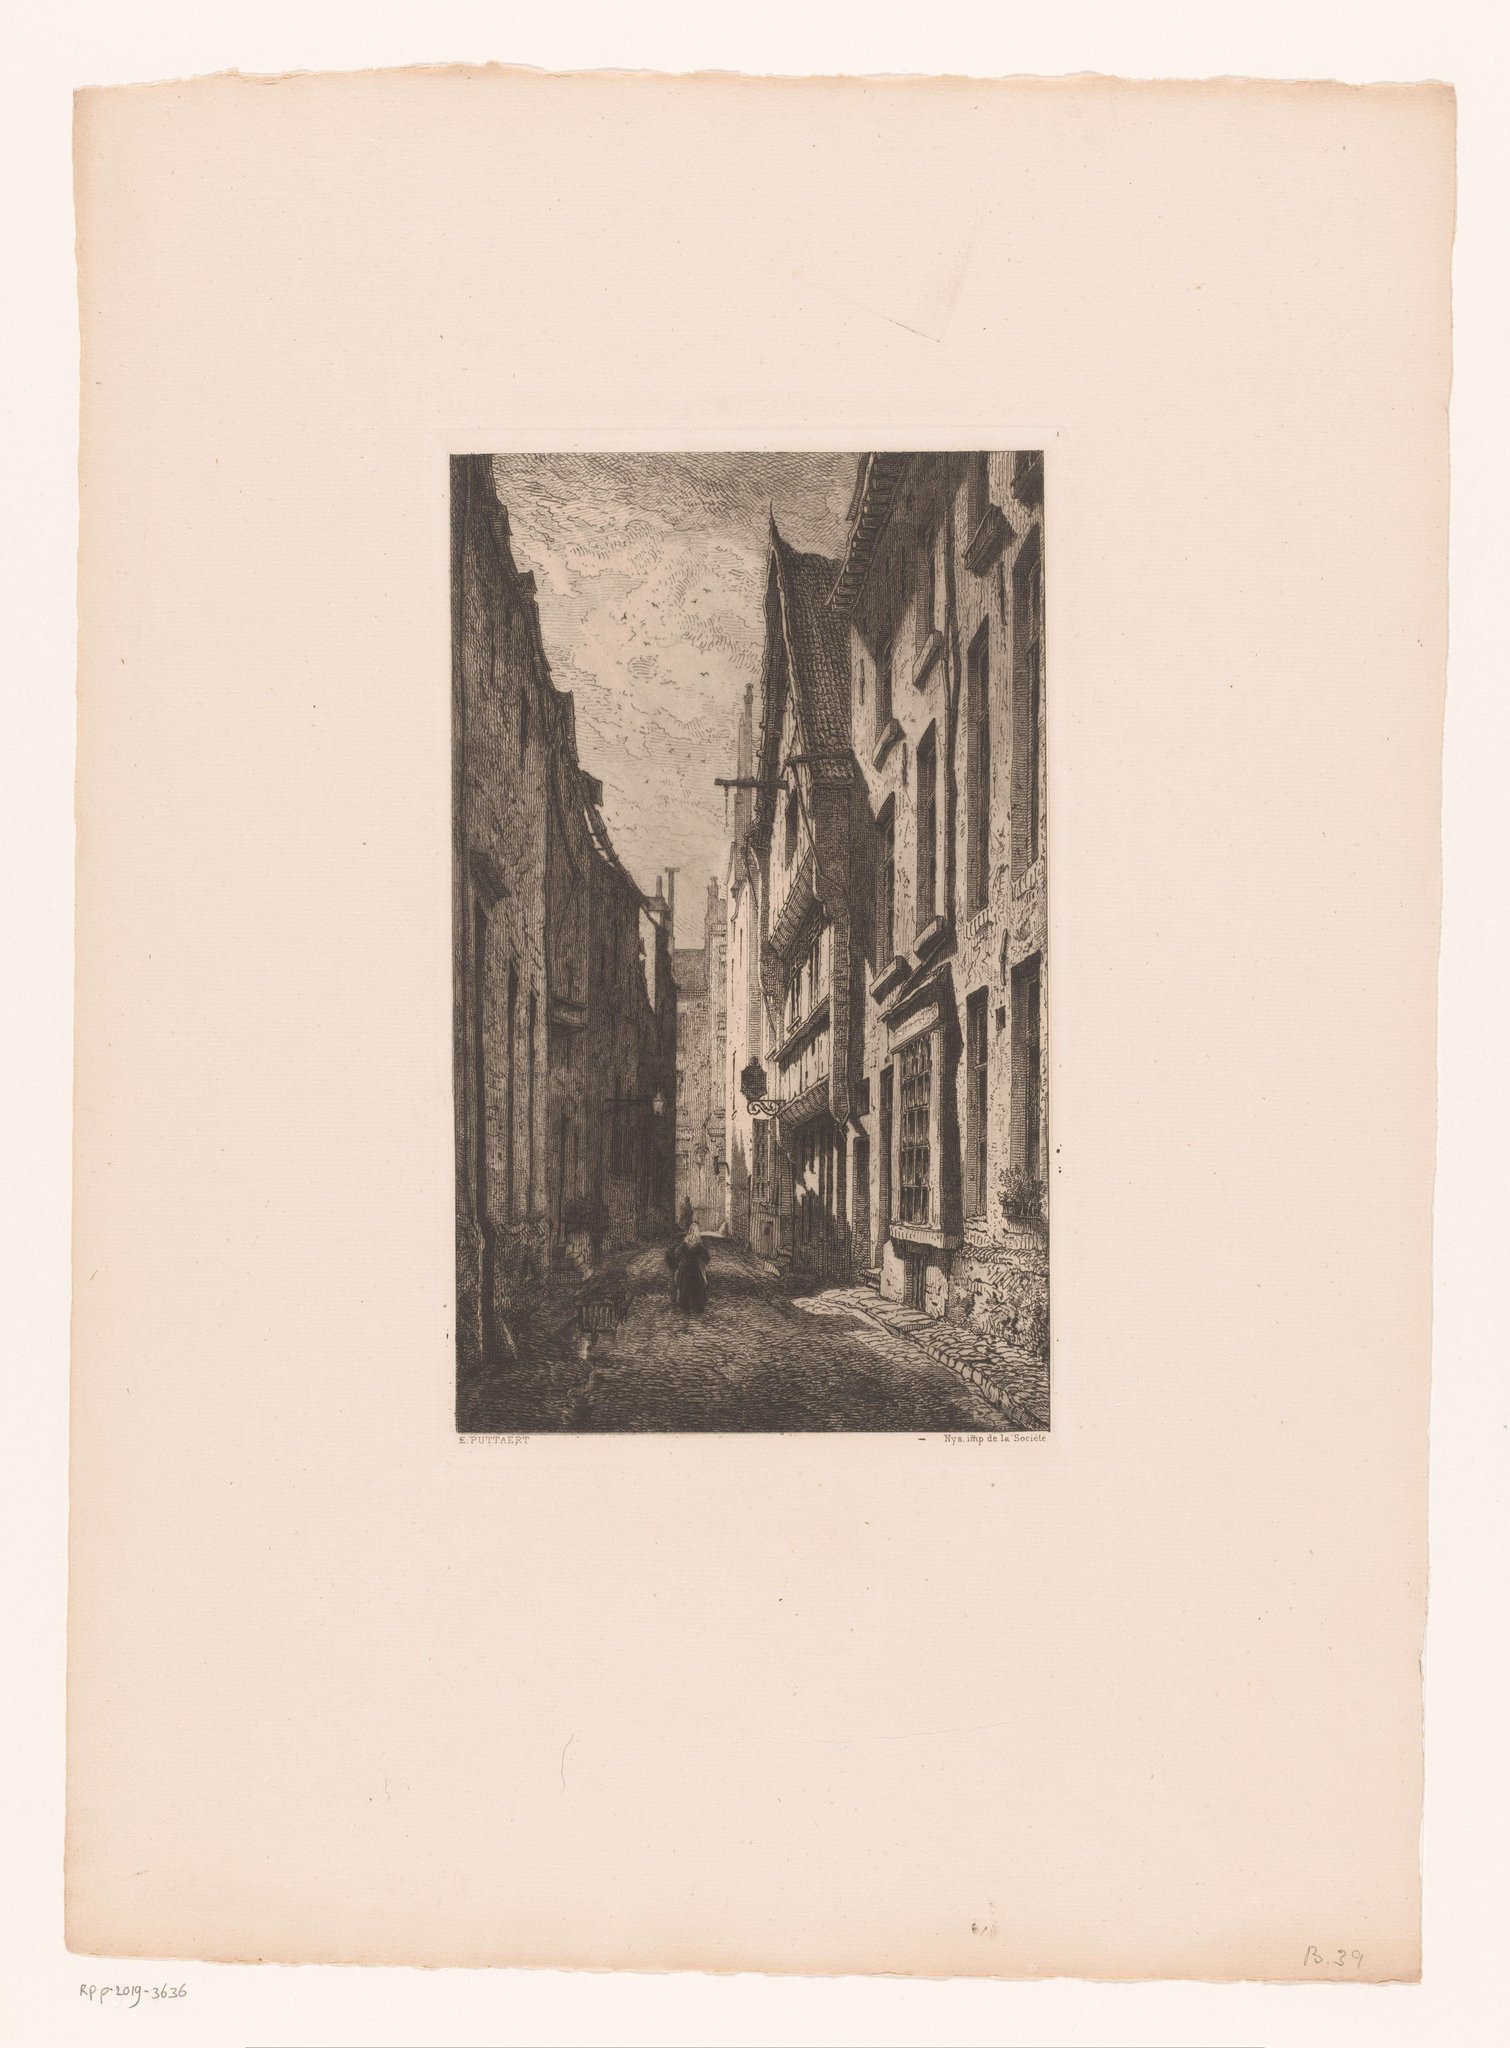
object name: print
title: Gezicht op een straat in Brussel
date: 1875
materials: paper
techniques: drypoint, etching, intaglio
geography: brussels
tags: street (+ city(-scape) with figures, staffage), brussels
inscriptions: collector's mark: Lugt 2228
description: Prent uit: Rops, Félicien (red.). Cahier d'études: eaux-fortes originales et inédites. Brussel: Felix Callewaert père, 1875. In deze publicatie verschenen onder de titel 'Petite rue des Pierres (Vieux-Bruxelles)'.